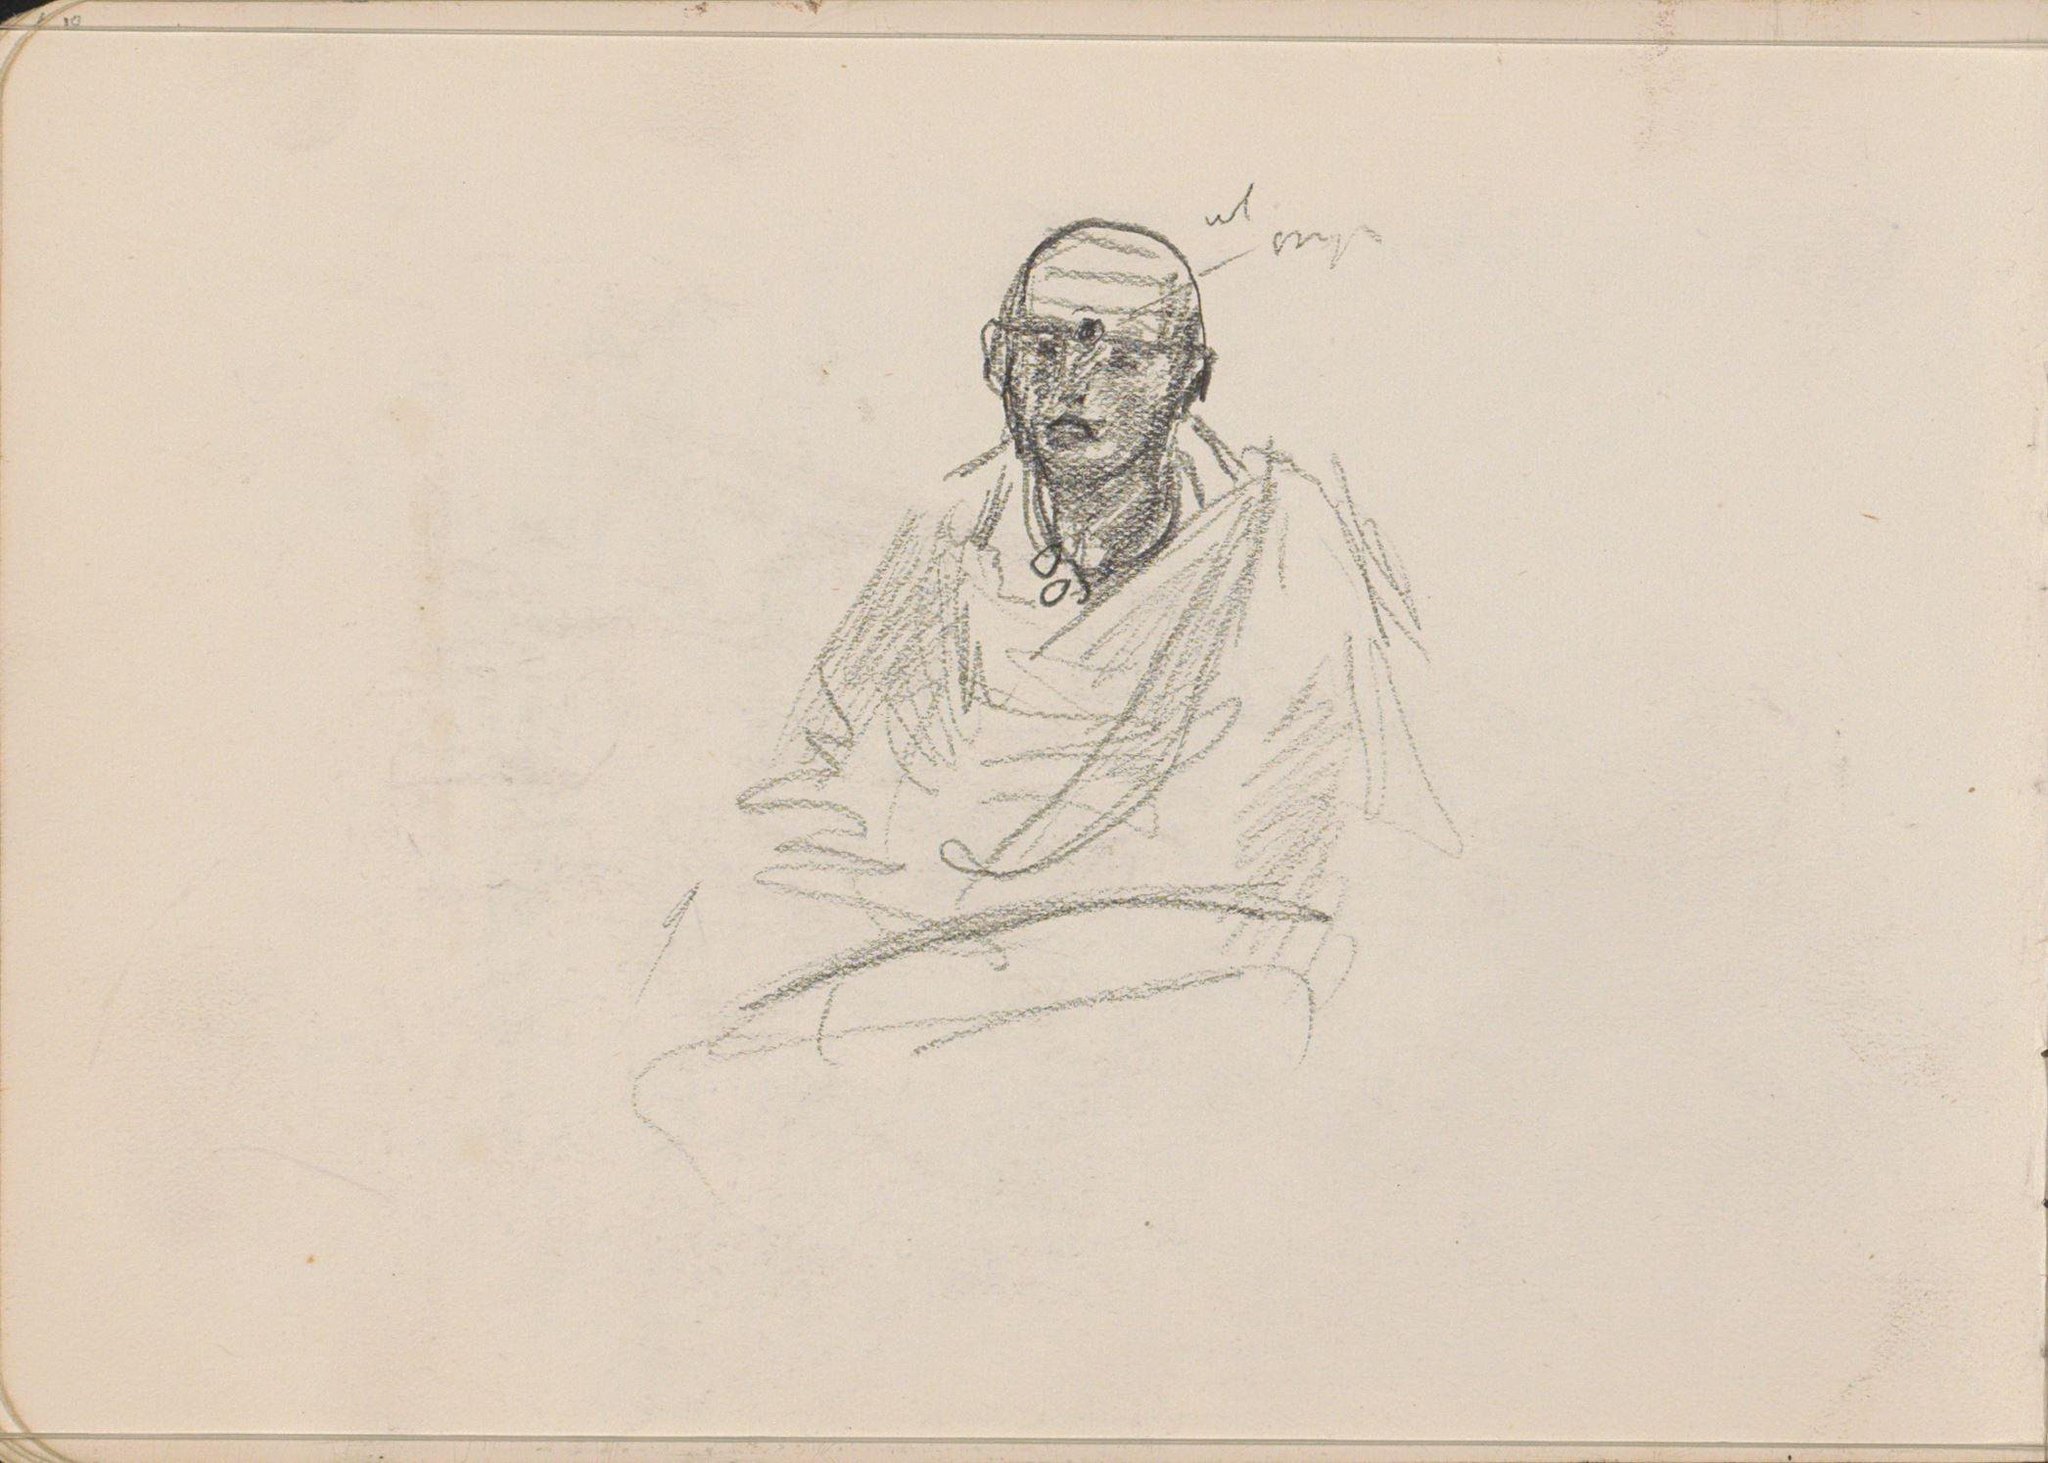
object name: sketchbook leaf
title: Zittende Indiër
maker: marius bauer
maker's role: draughtsman, print maker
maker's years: 1867-1932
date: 1924-1925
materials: paper, pencil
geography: india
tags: sitting figure, asiatic races and peoples: indians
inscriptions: kleurnotitie, handgeschreven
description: Pagina 10 uit een schetsboek met 23 bladen.